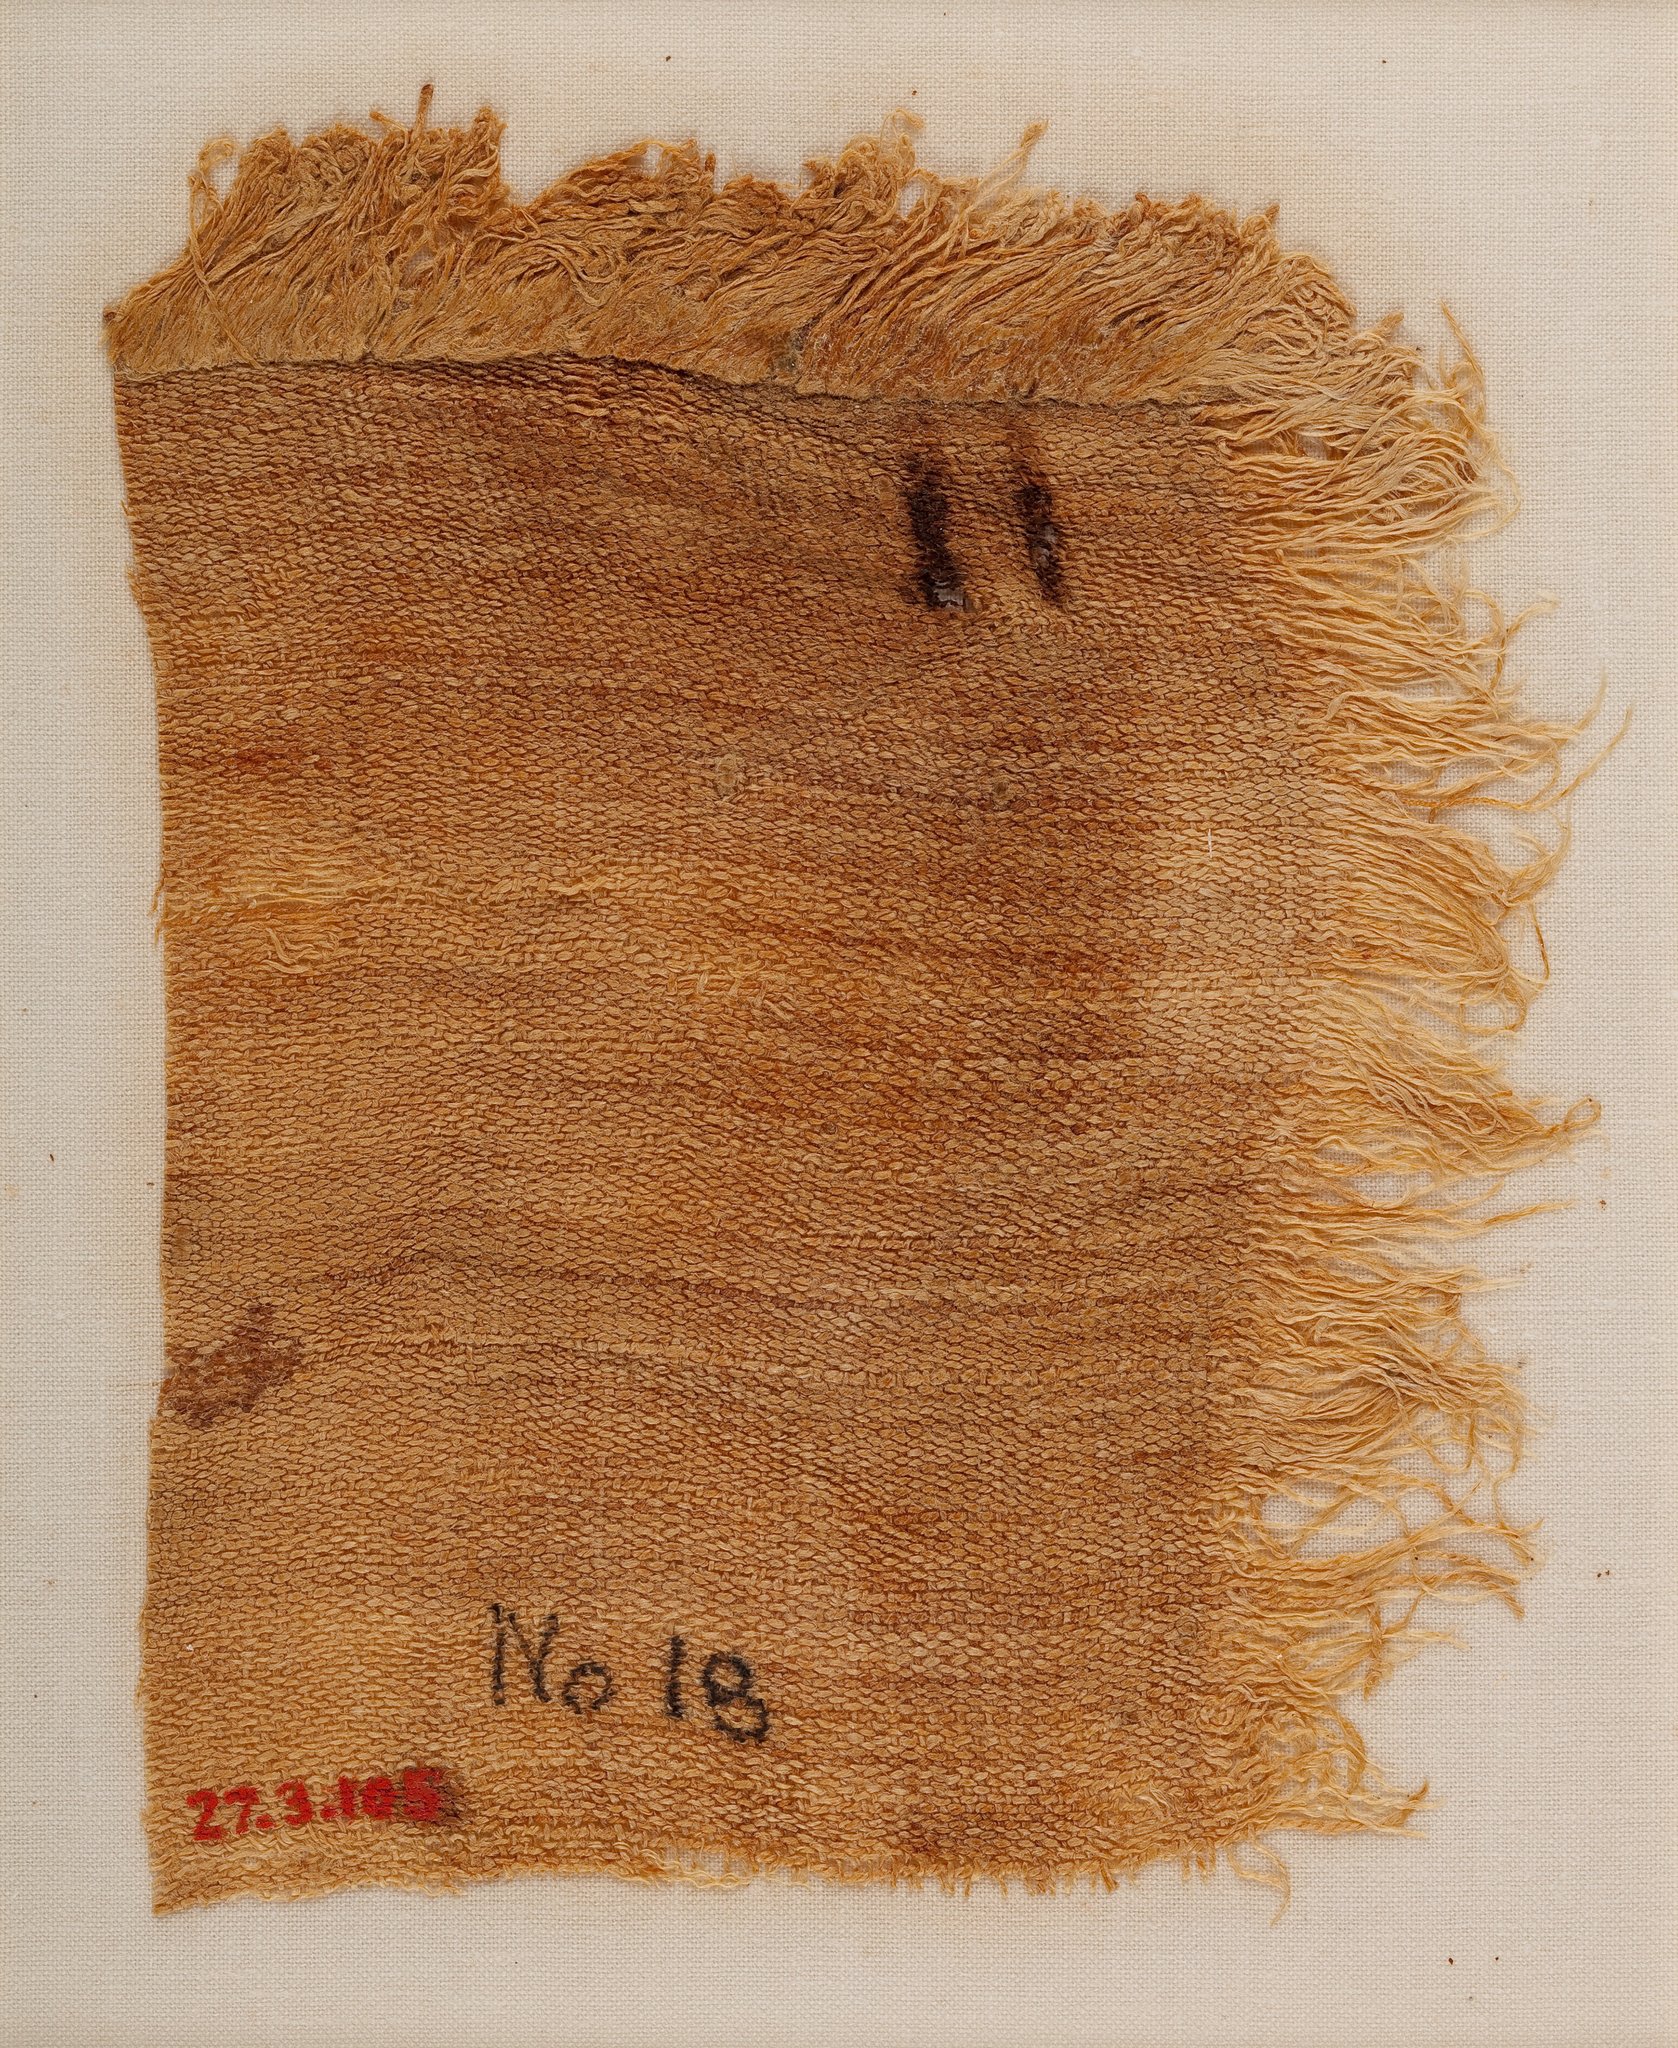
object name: linen mark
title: Linen mark (Type X)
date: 1961-1917 BCE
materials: linen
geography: egypt